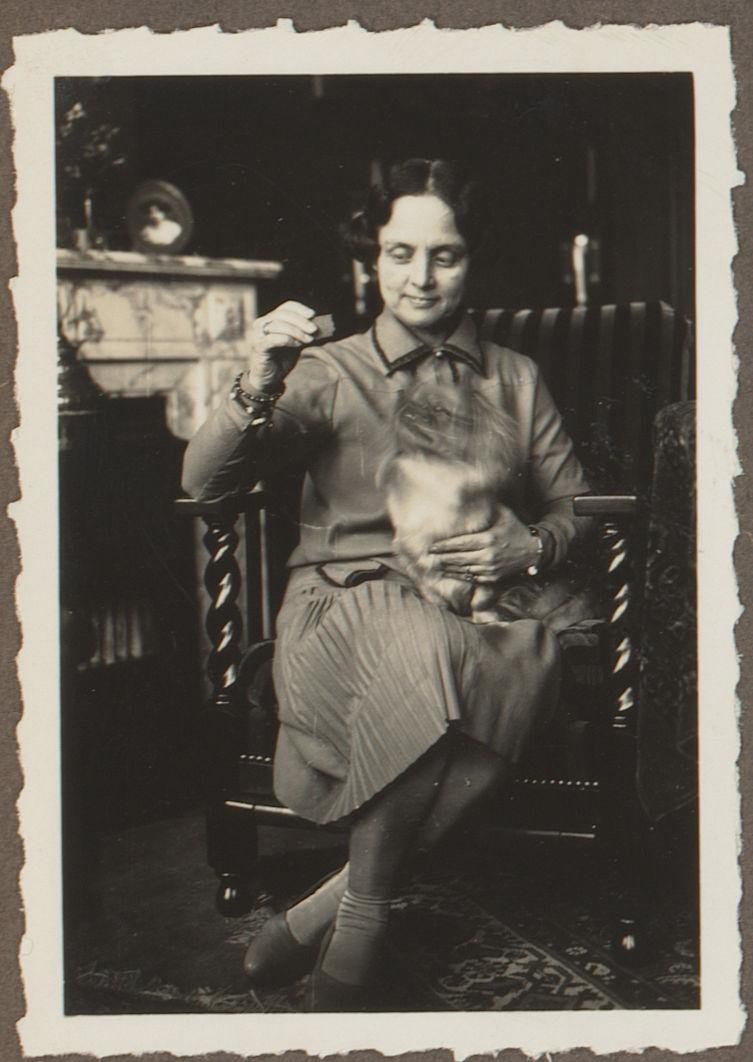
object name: photograph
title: Portret van Henriëtte Wassink met hond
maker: Anonymous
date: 1930-1935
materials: paper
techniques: gelatin silver print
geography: netherlands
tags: batavia, the hague, henriëtte wassink, historical persons - bb - woman, dog, netherlands